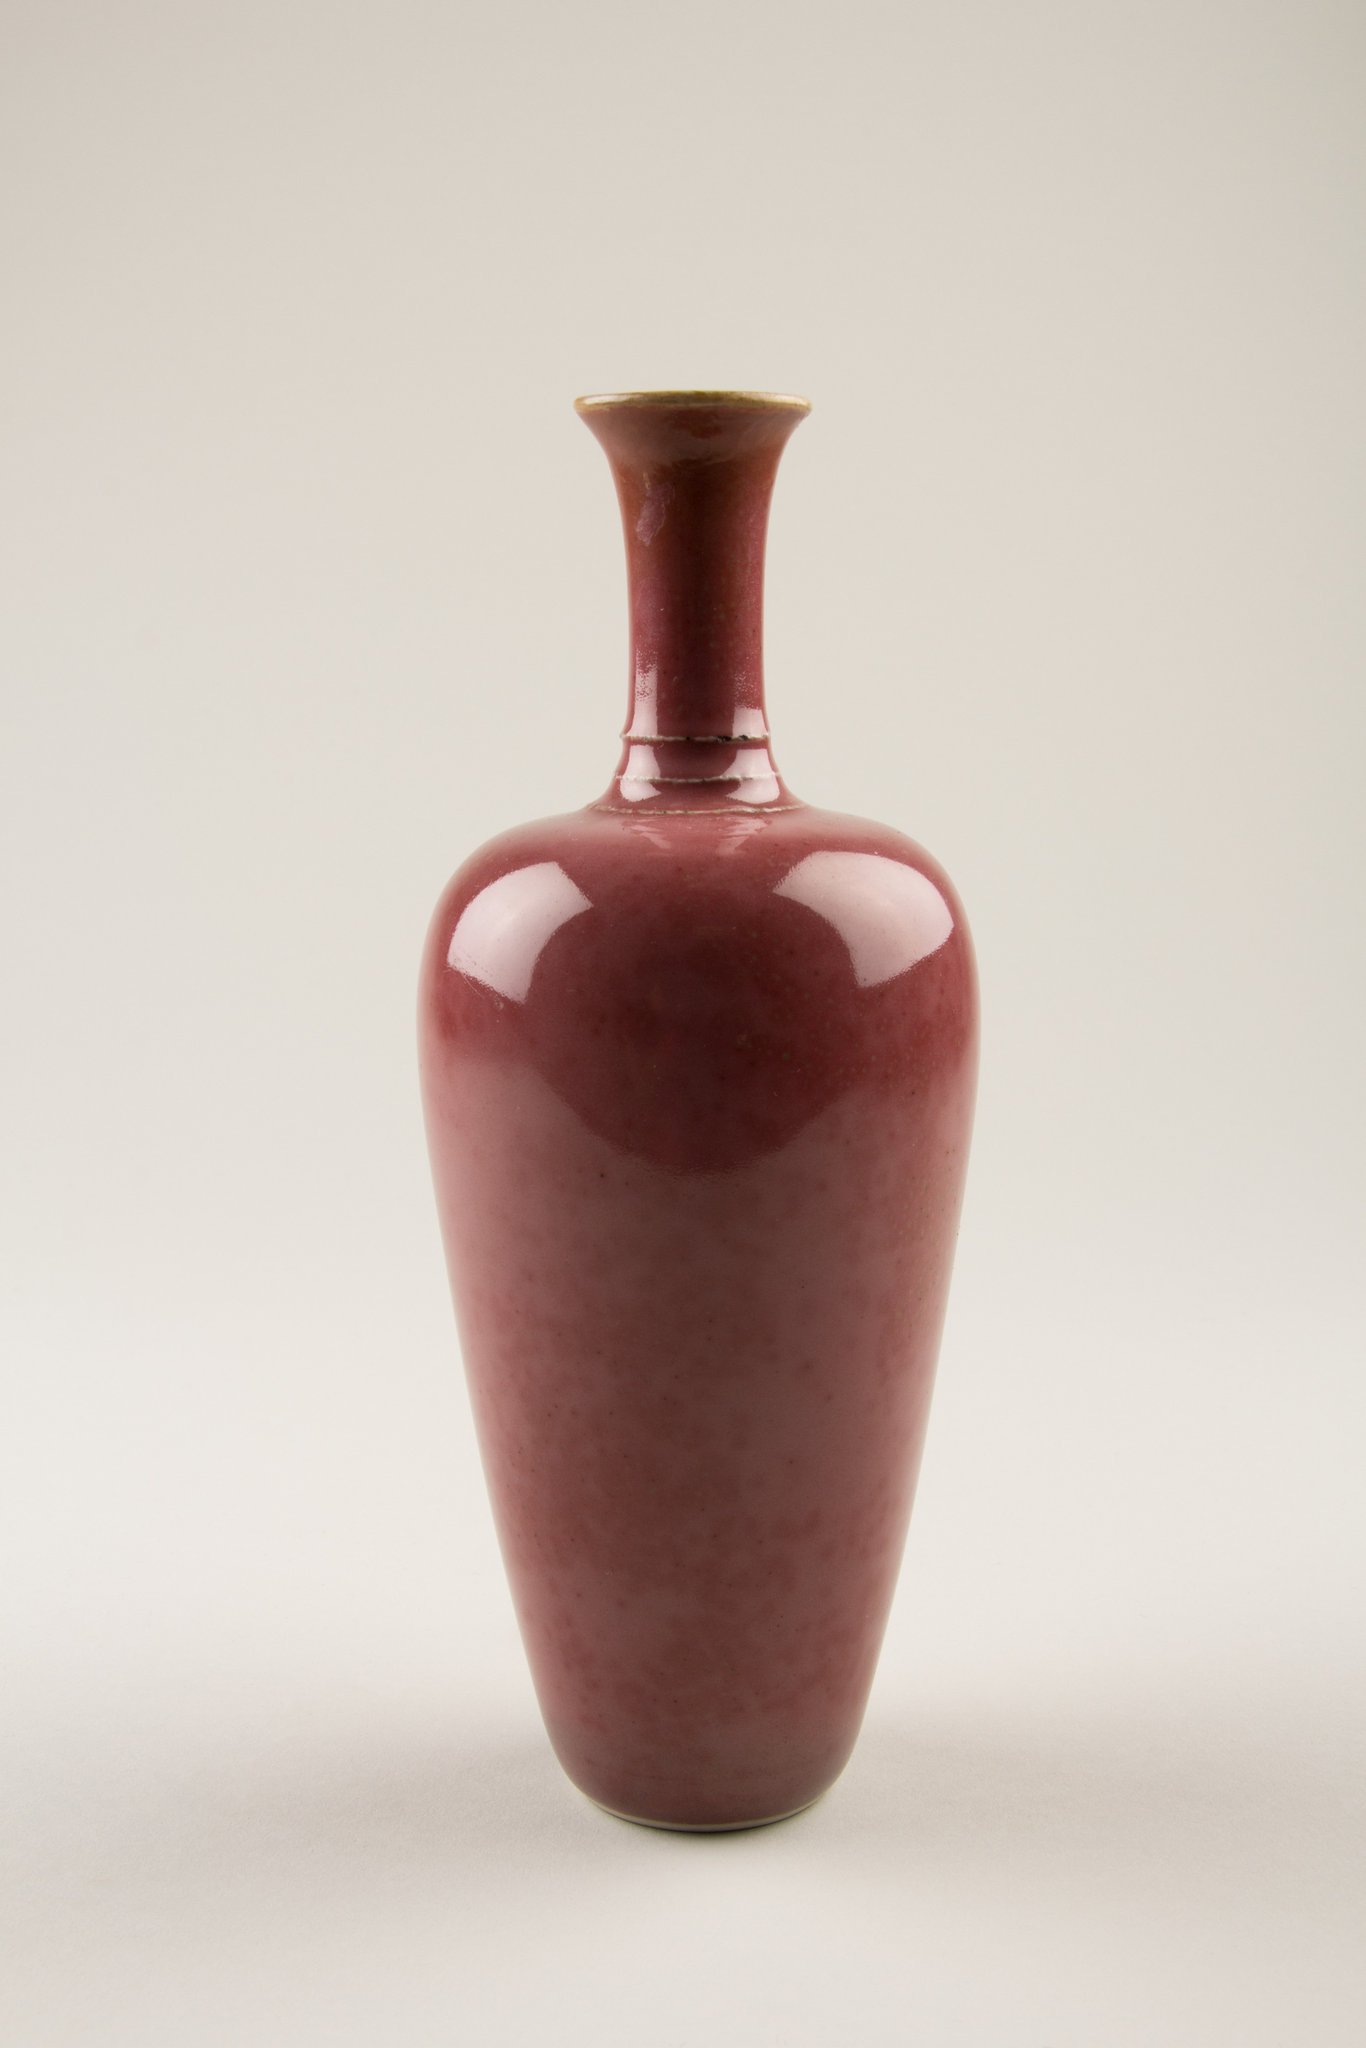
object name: vase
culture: chinese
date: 1662-1722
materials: porcelain